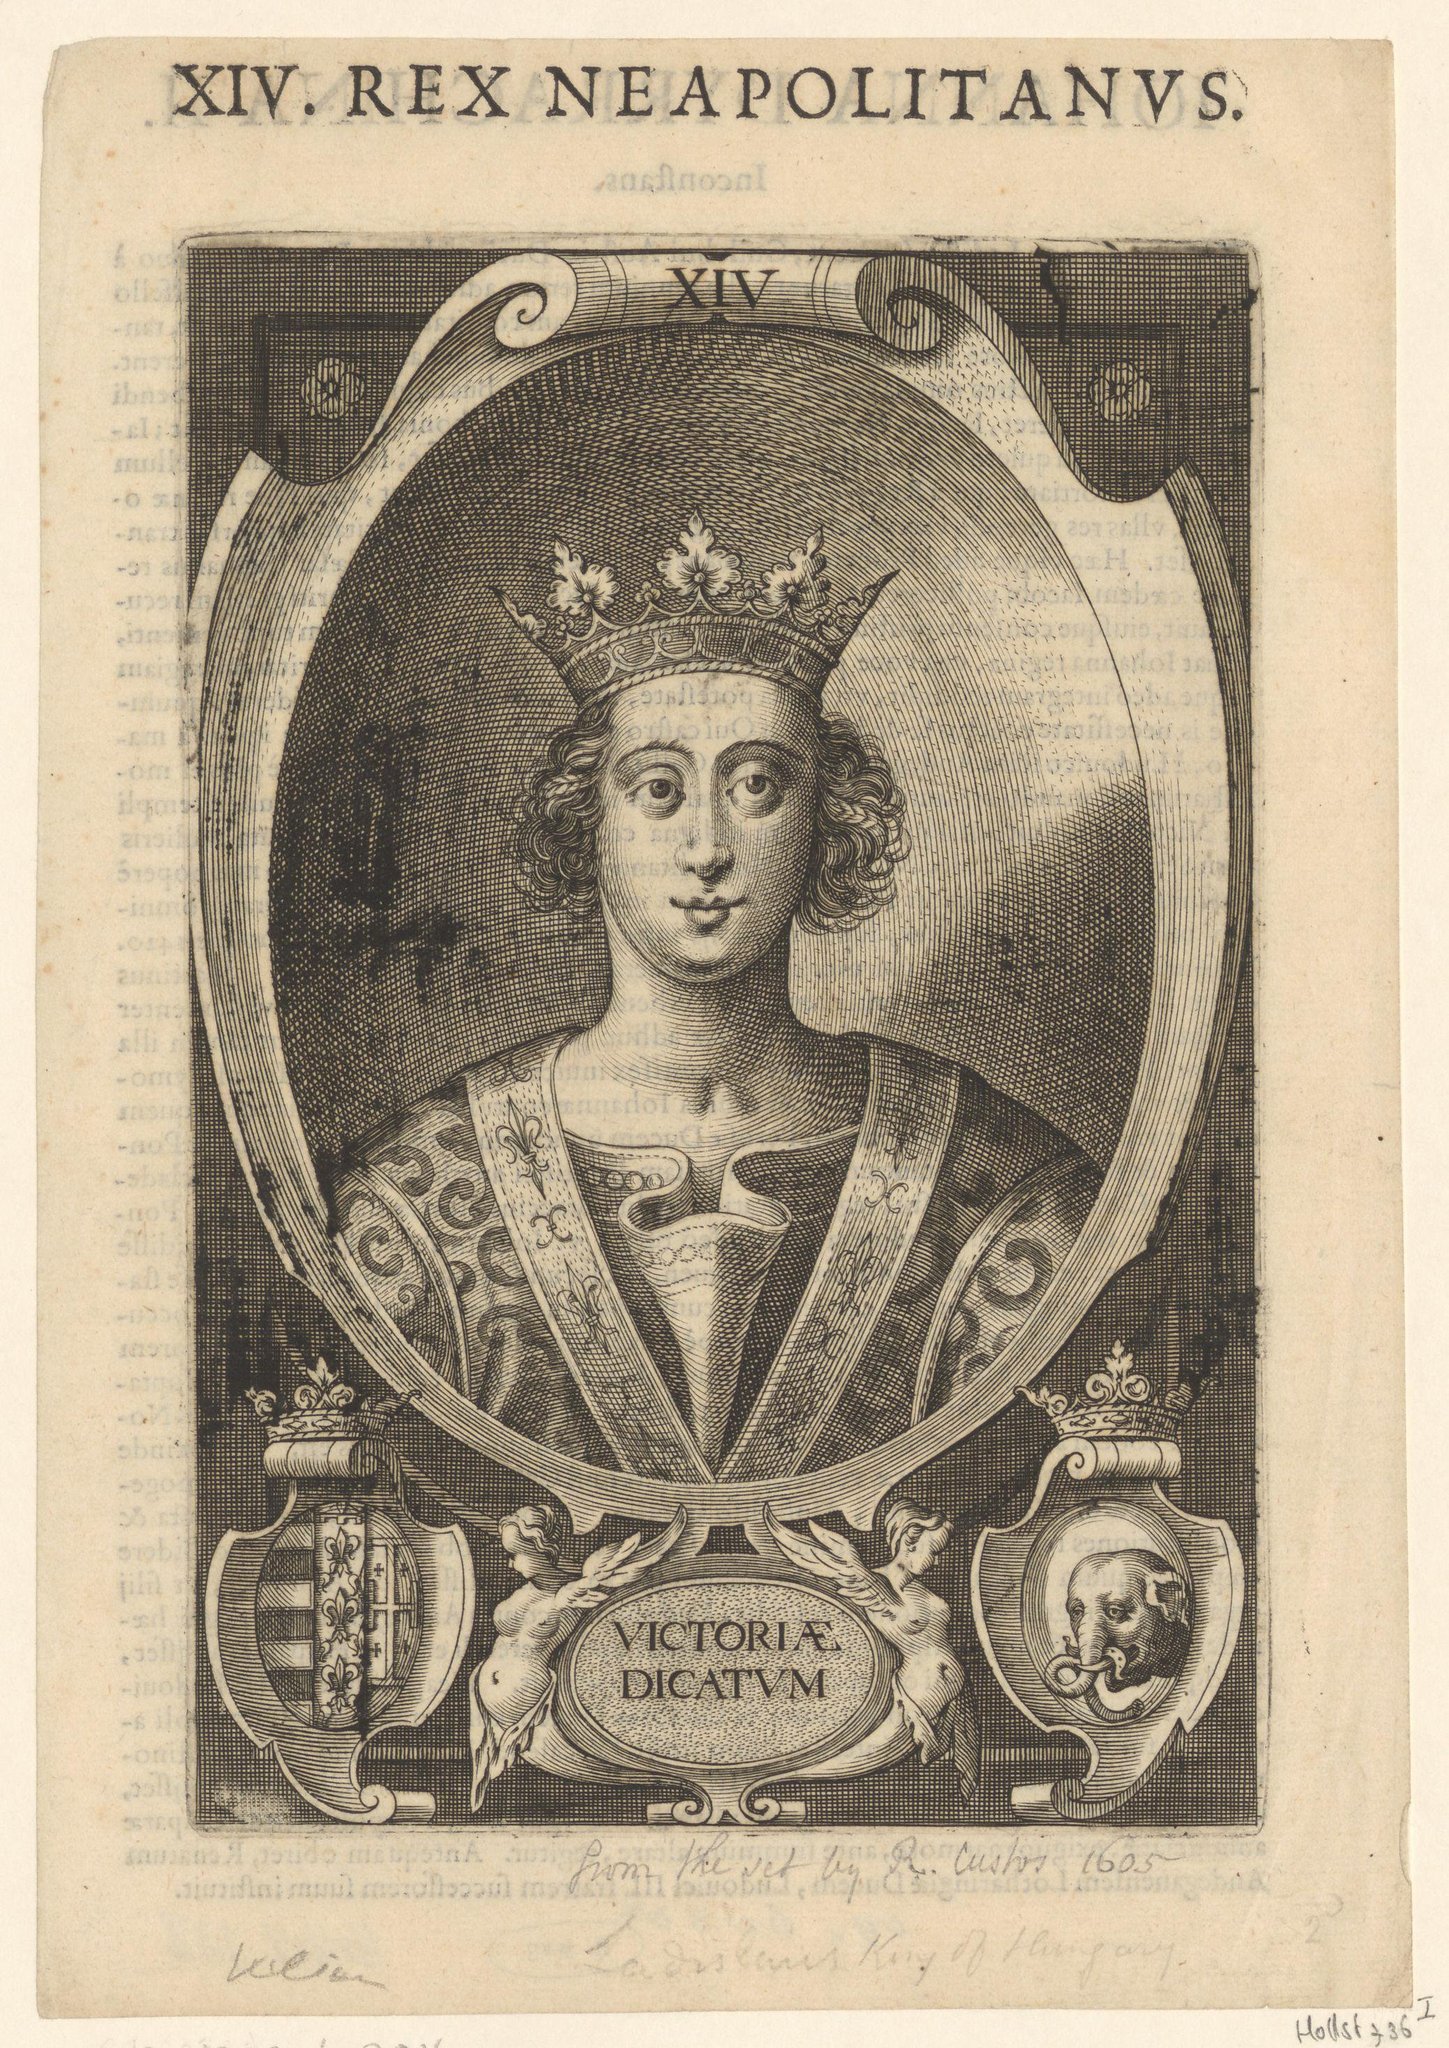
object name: book illustration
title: Portret van Ladislaus, koning van Napels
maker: lucas kilian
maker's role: draughtsman, print maker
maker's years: 1579-1637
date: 1589-1624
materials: paper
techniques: engraving, etching, letterpress printing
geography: augsburg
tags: naples, historical persons, king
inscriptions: collector's mark: Lugt 2228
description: Deze prent is gebruikt in: Mazzella, Scipione, Kilian, Lucas en Custos, Dominicus. Der Neapolitanische Koenige Leben und Bildnisse (...). Augsburg: Lucas Kilian, 1624.